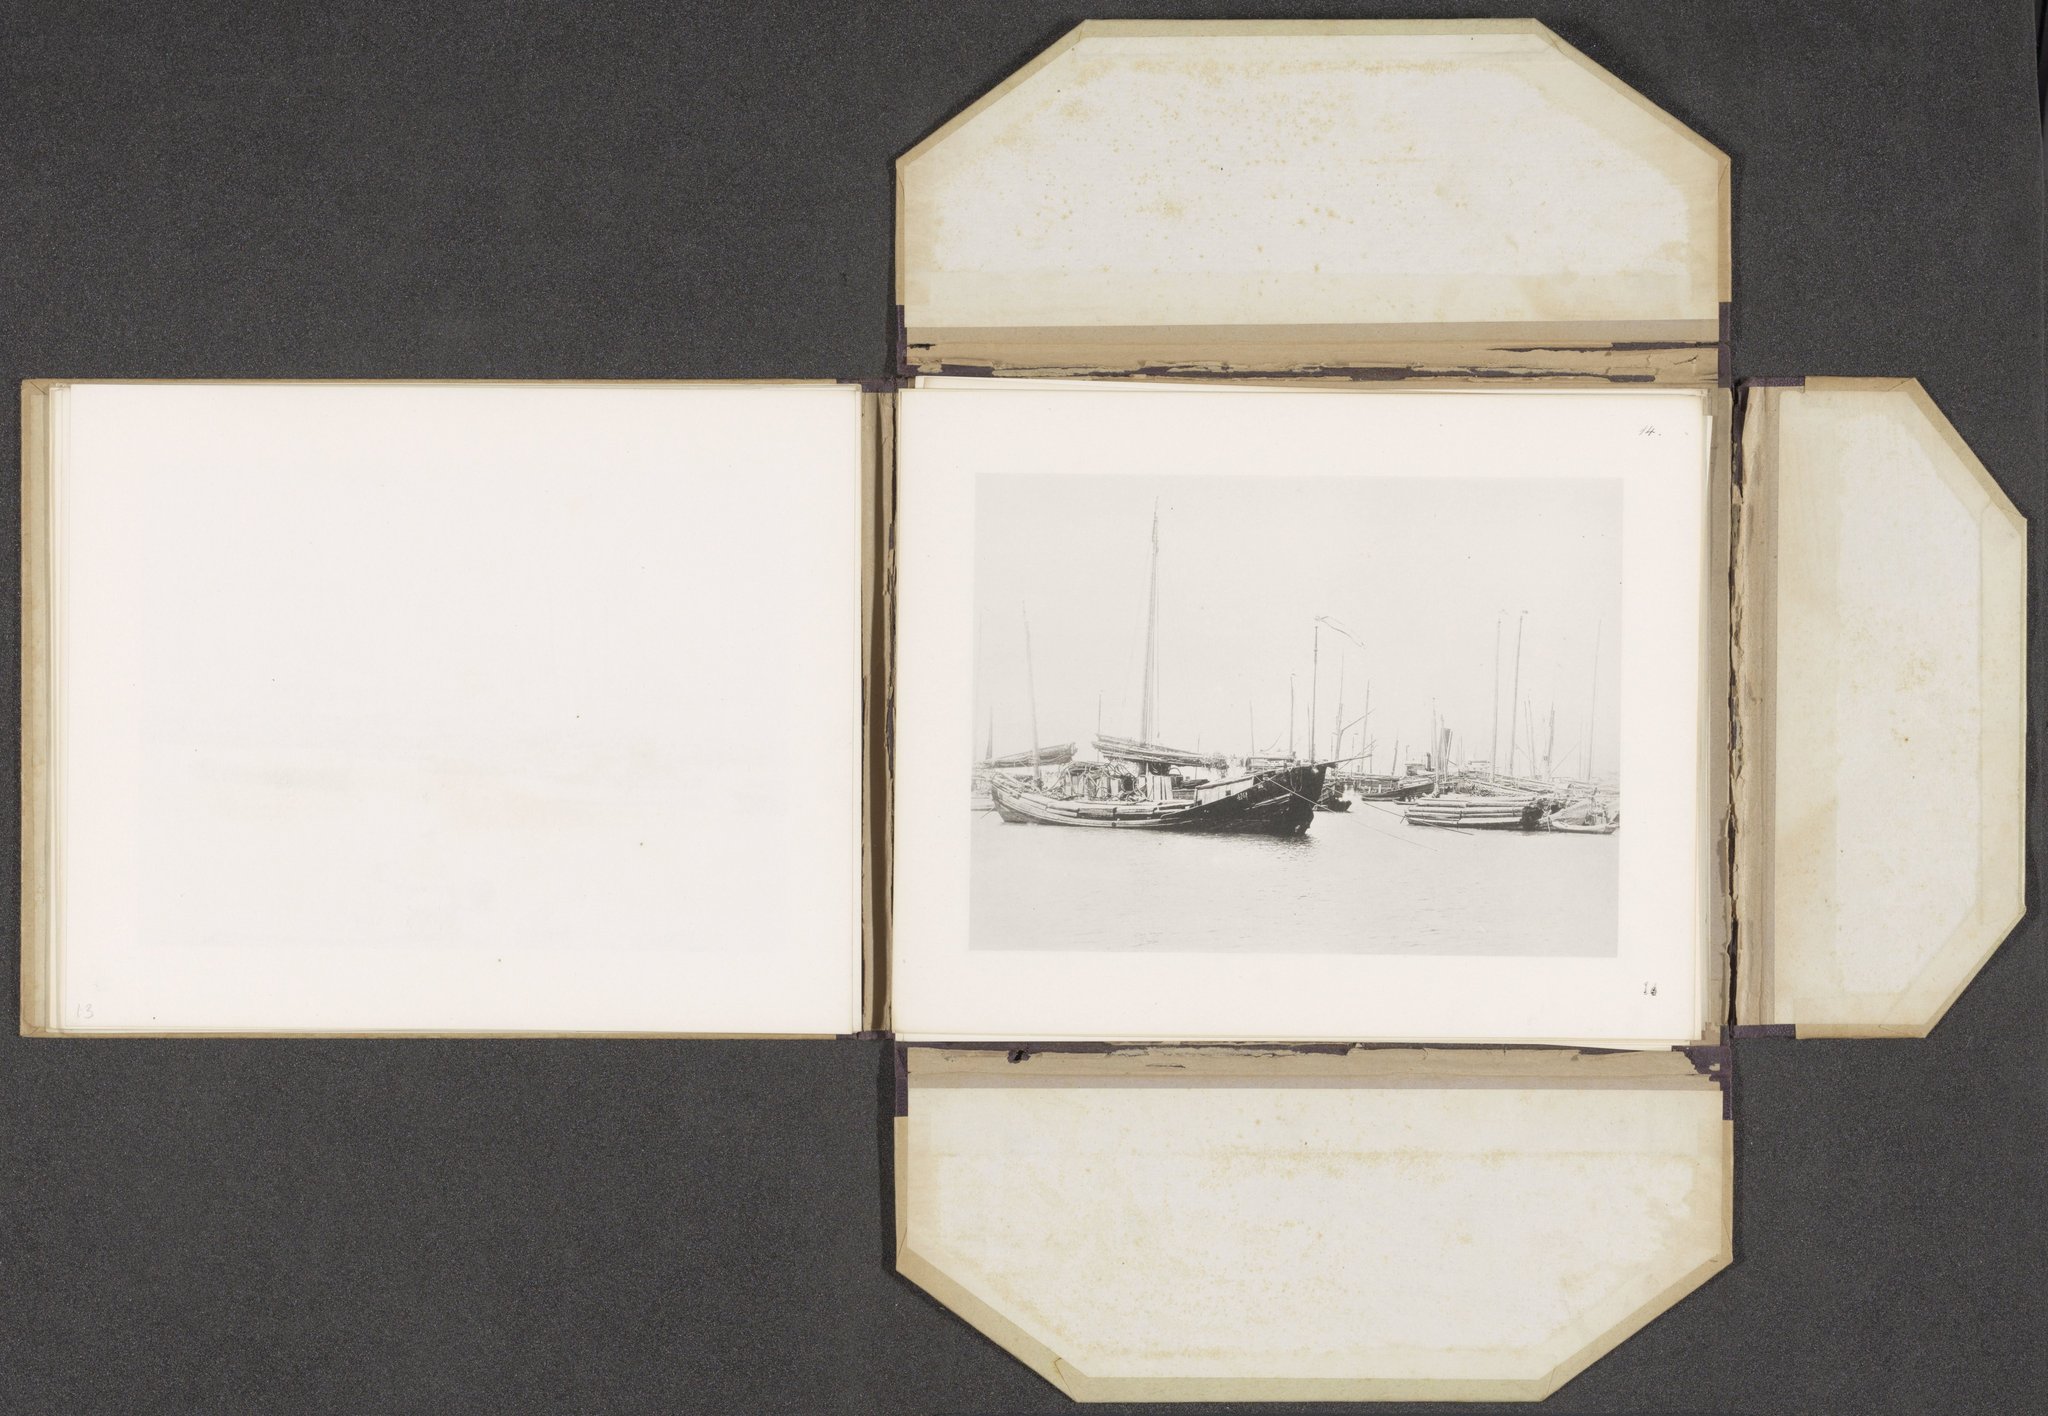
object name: page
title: Chinese jonken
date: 1898-1899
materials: paper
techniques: photograph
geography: manchuria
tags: ships (in general)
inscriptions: number: ‘14’